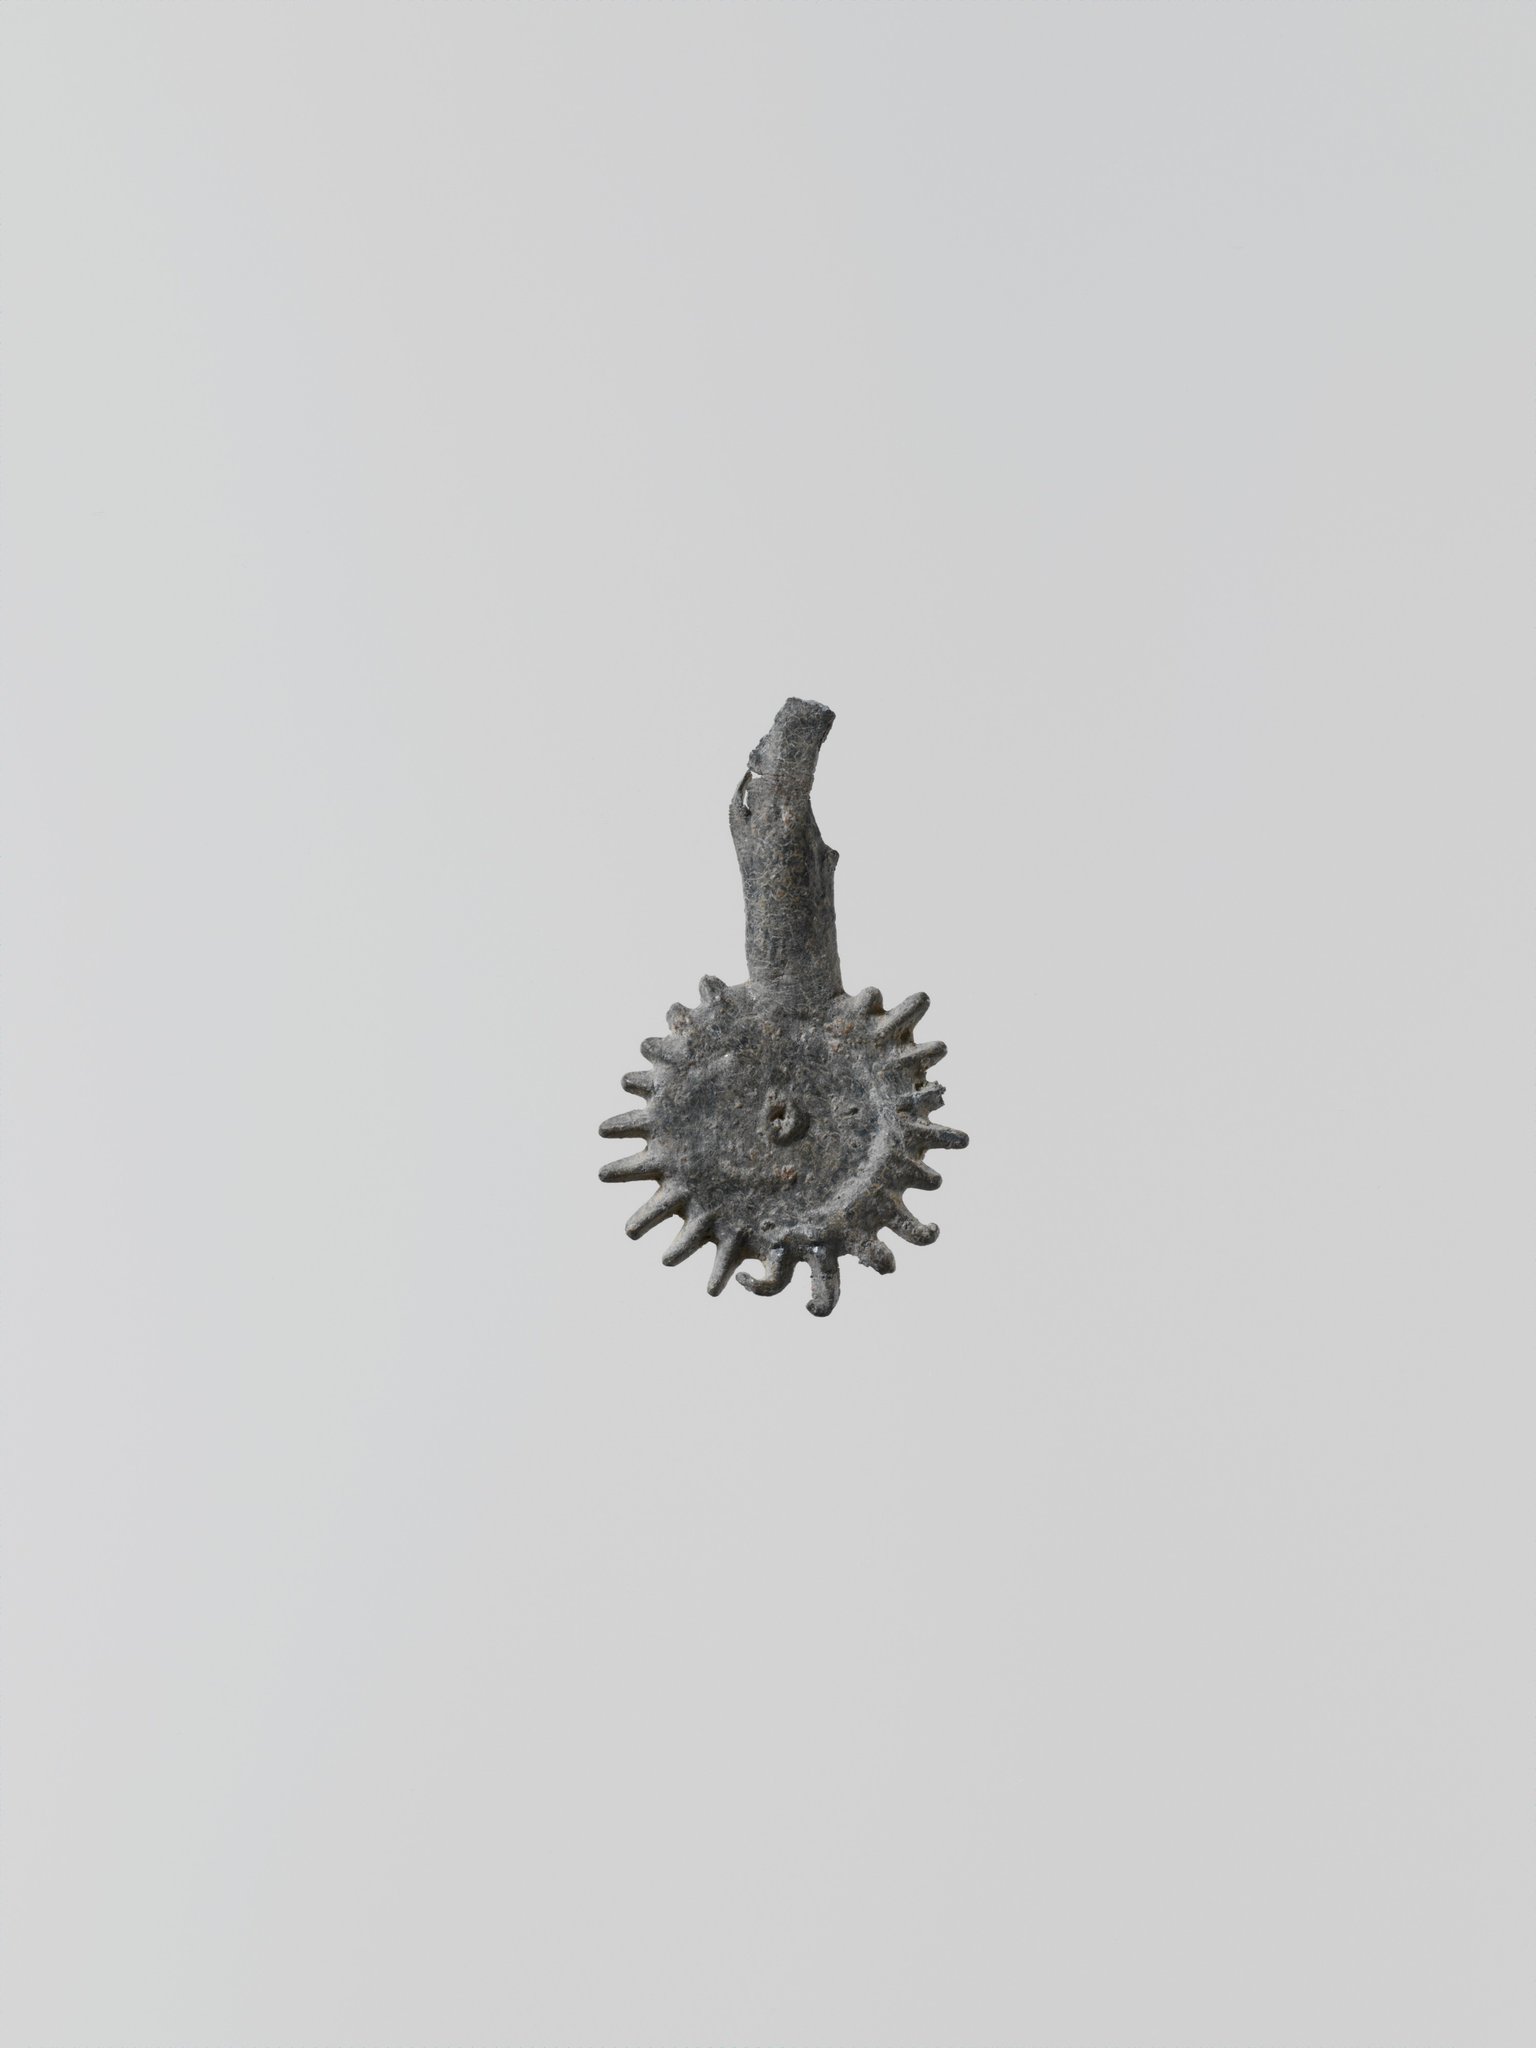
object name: ornament, 14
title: Lead ornament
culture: greek, laconian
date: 600-401 BCE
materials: lead